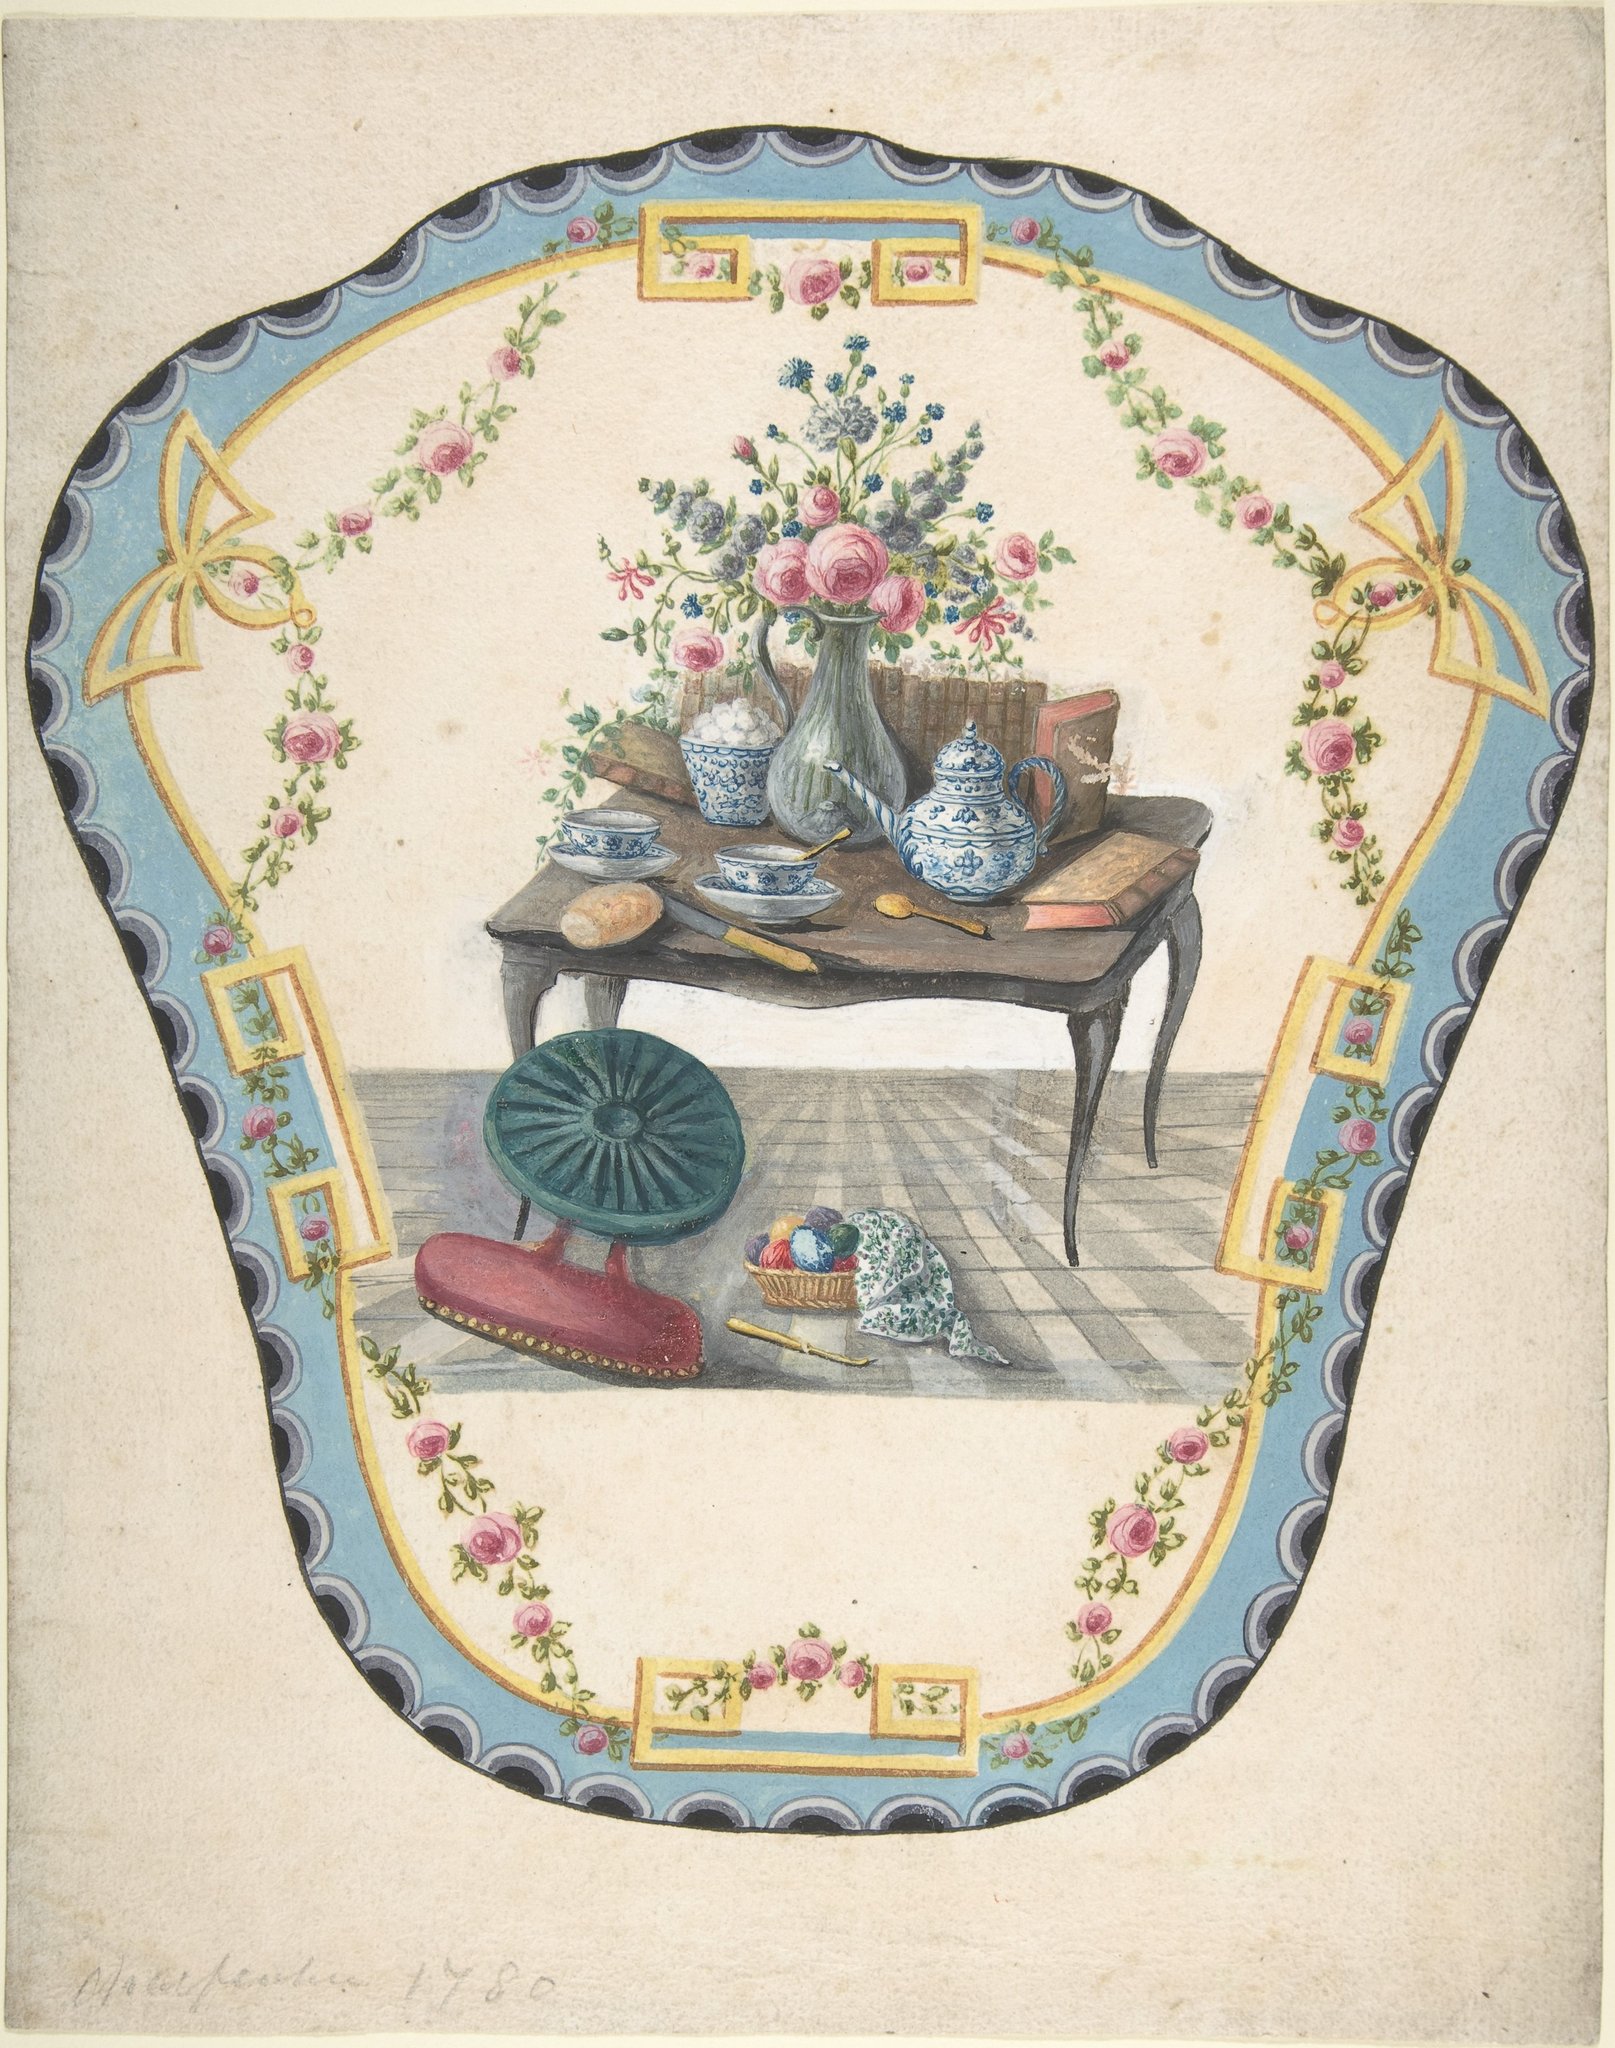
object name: drawing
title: Design for a Firescreen with a Table with a Vase of Flowers, Books, and Teapot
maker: eugène charpentier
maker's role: artist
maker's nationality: french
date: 1767-1800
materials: gouache, graphite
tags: books,flowers,tables,teapots,vases